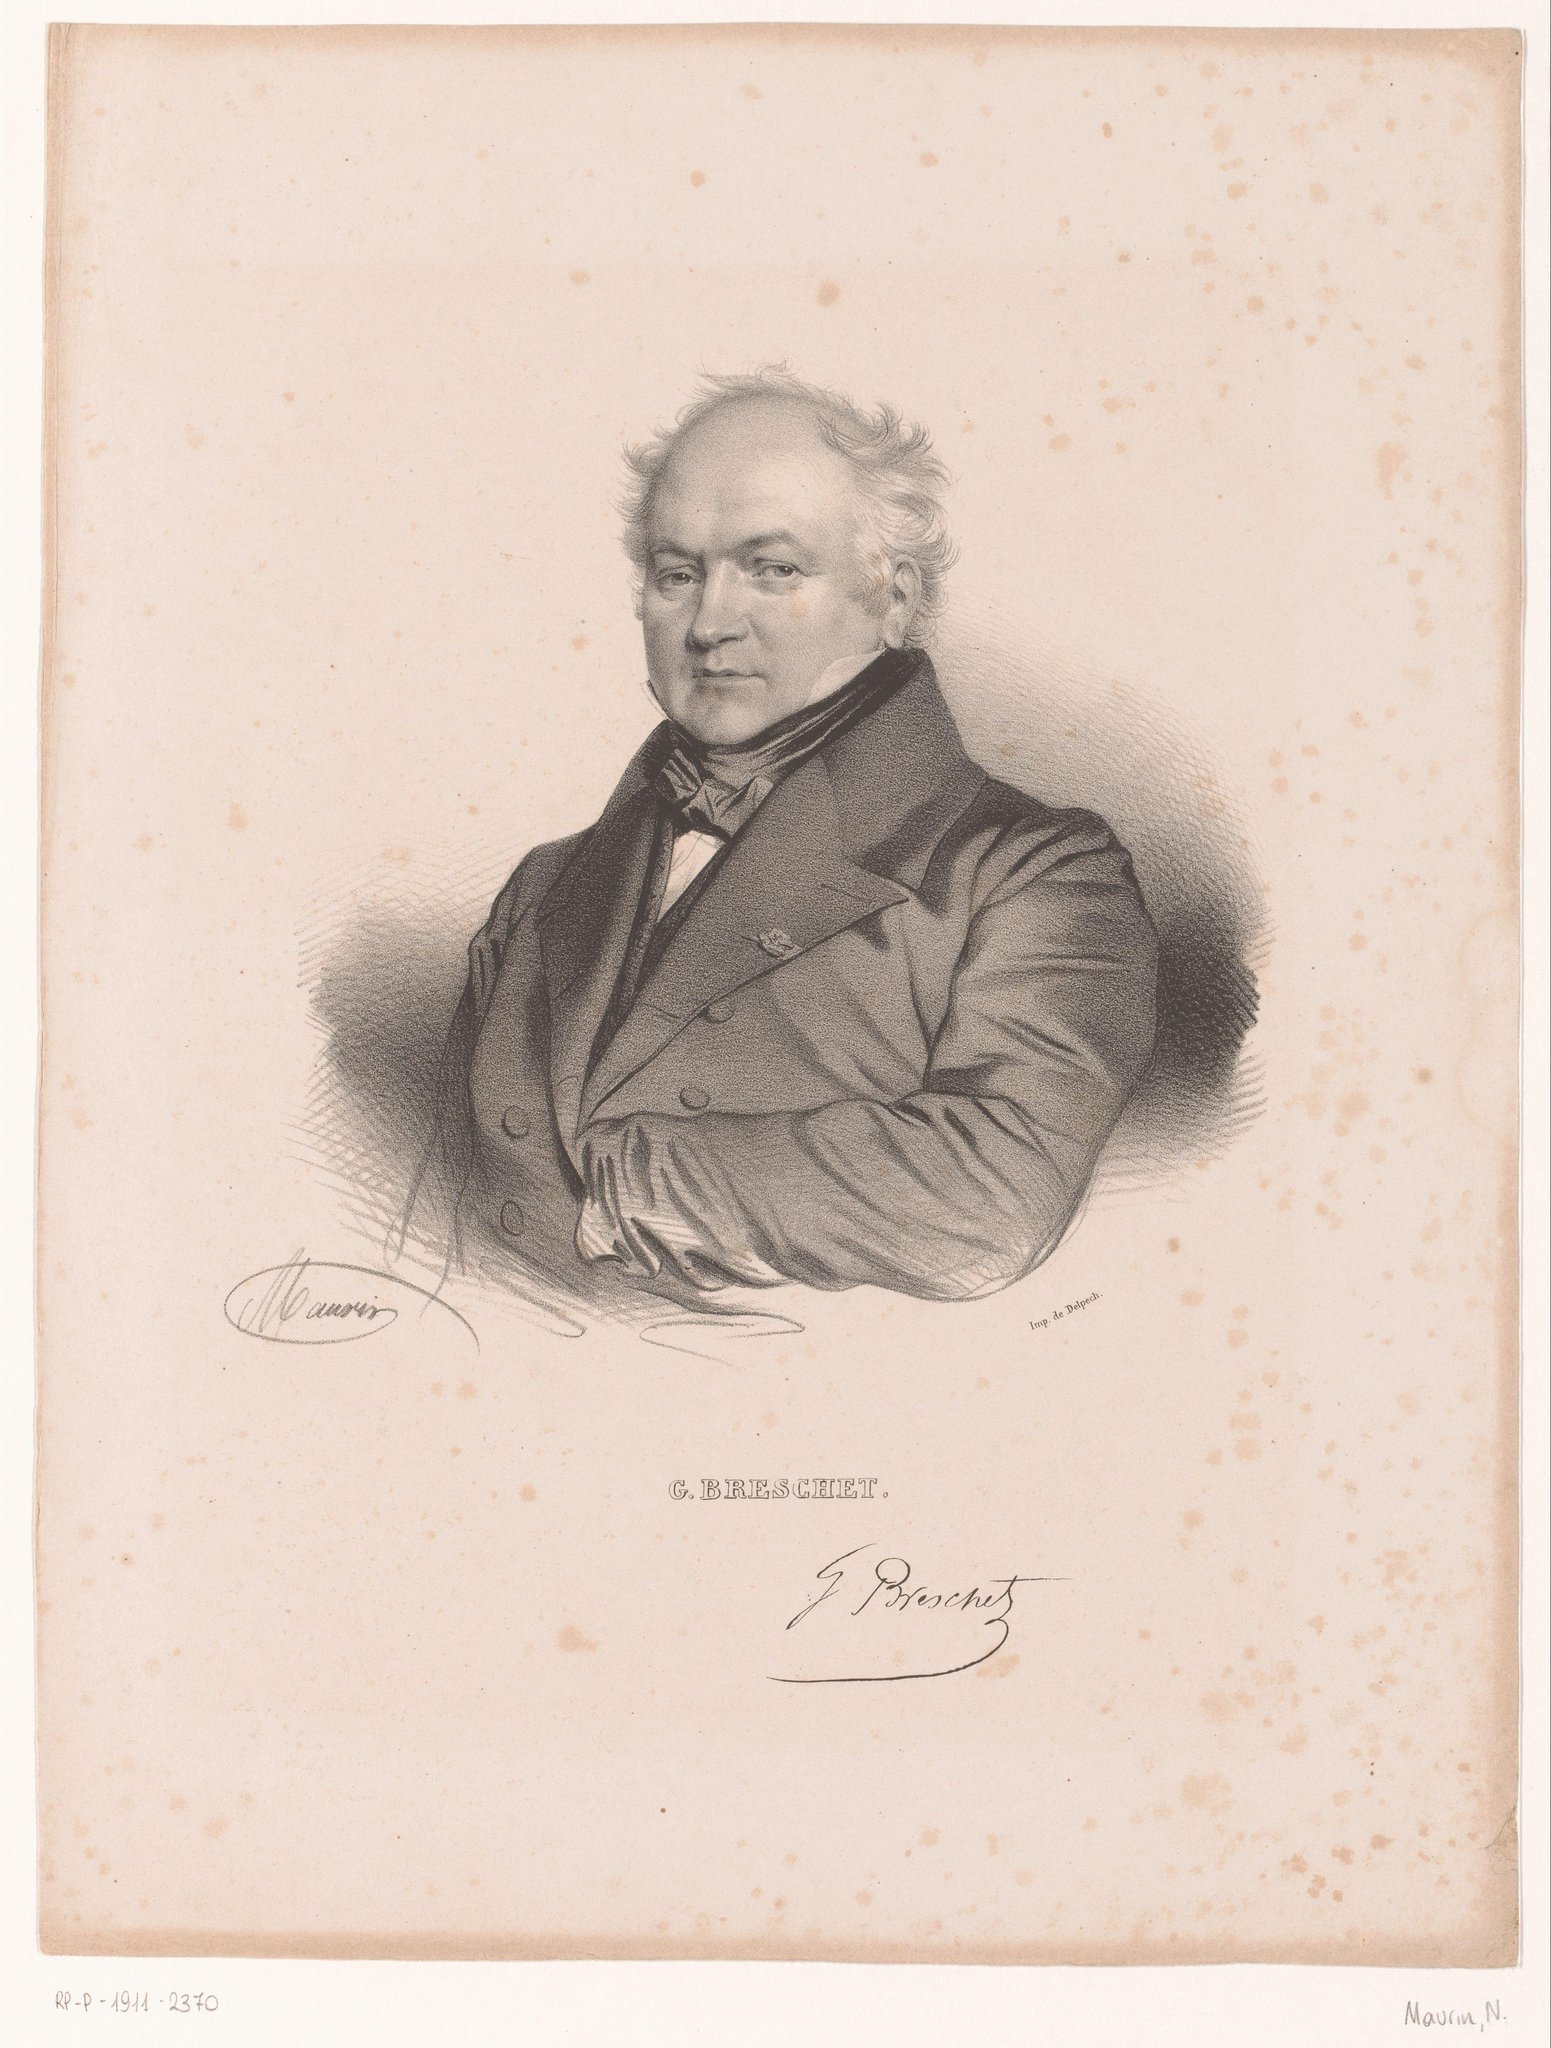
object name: print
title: Portret van Gilbert Breschet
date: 1838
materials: paper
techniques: lithograph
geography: paris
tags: paris, historical persons, physician, doctor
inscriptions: collector's mark: Lugt 2228